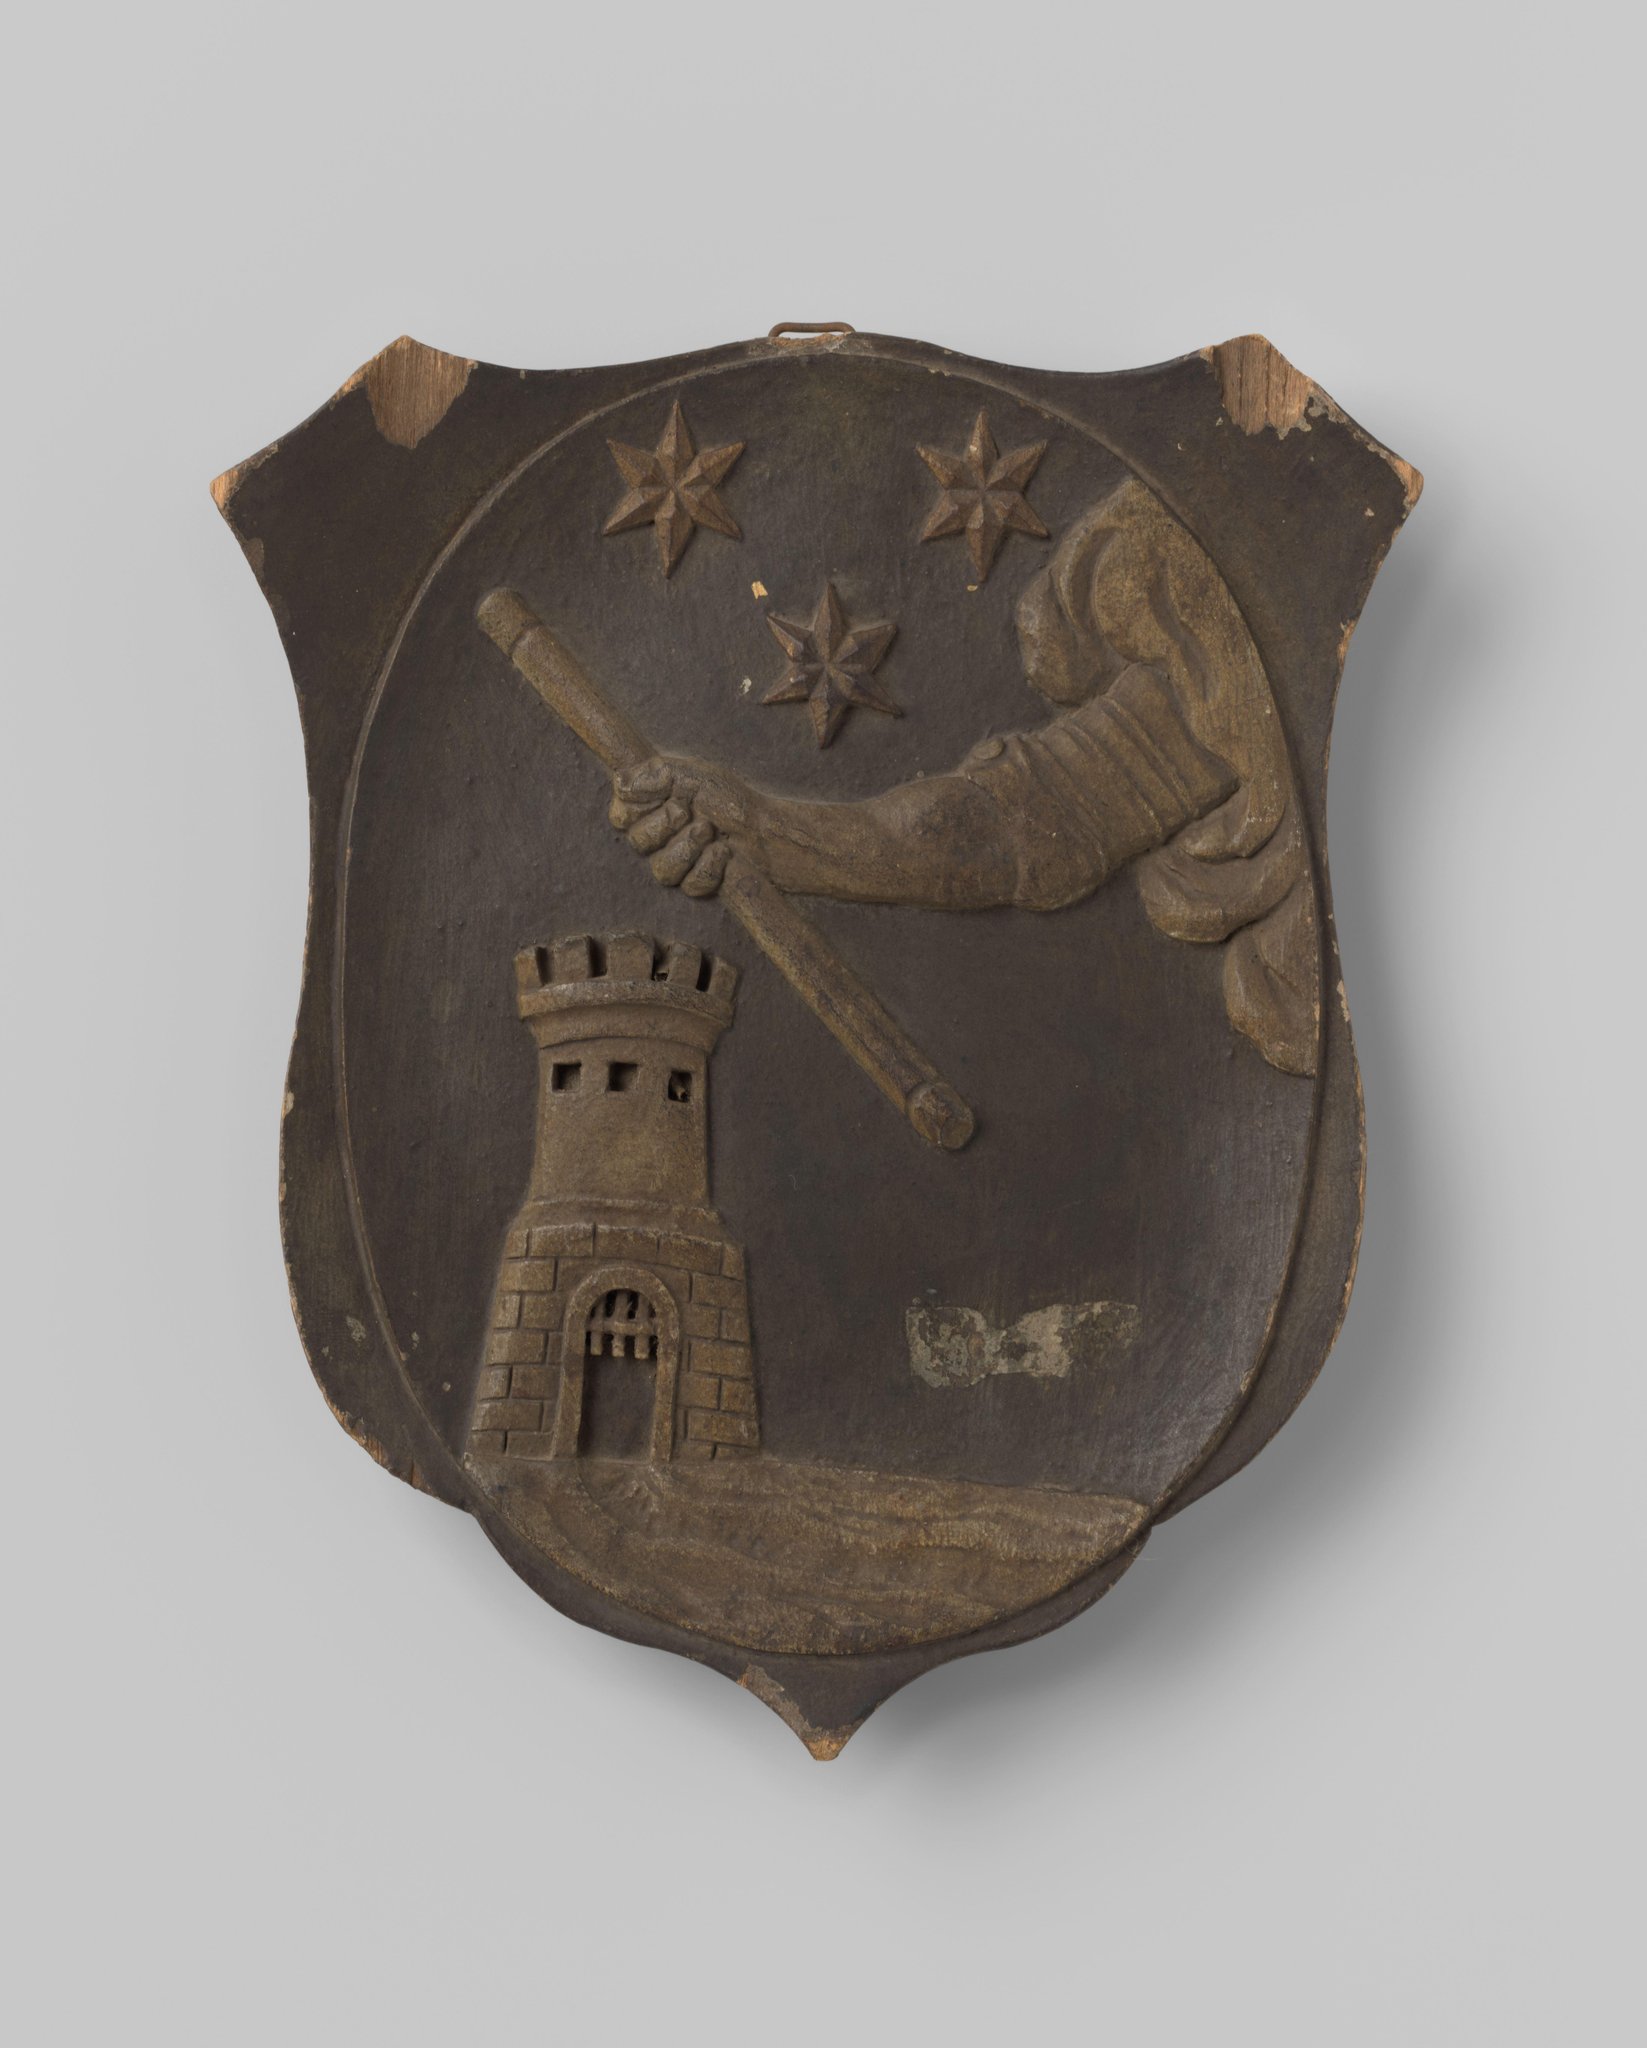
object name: wapenschild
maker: Anonymous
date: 1400-1950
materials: wood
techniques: polychromy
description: Wapenschild van lindenhout zwartgelakt met goudkleurige beeltenis: Arm komt uit wolken en heeft staf in de hand, drie sterren en een toren.